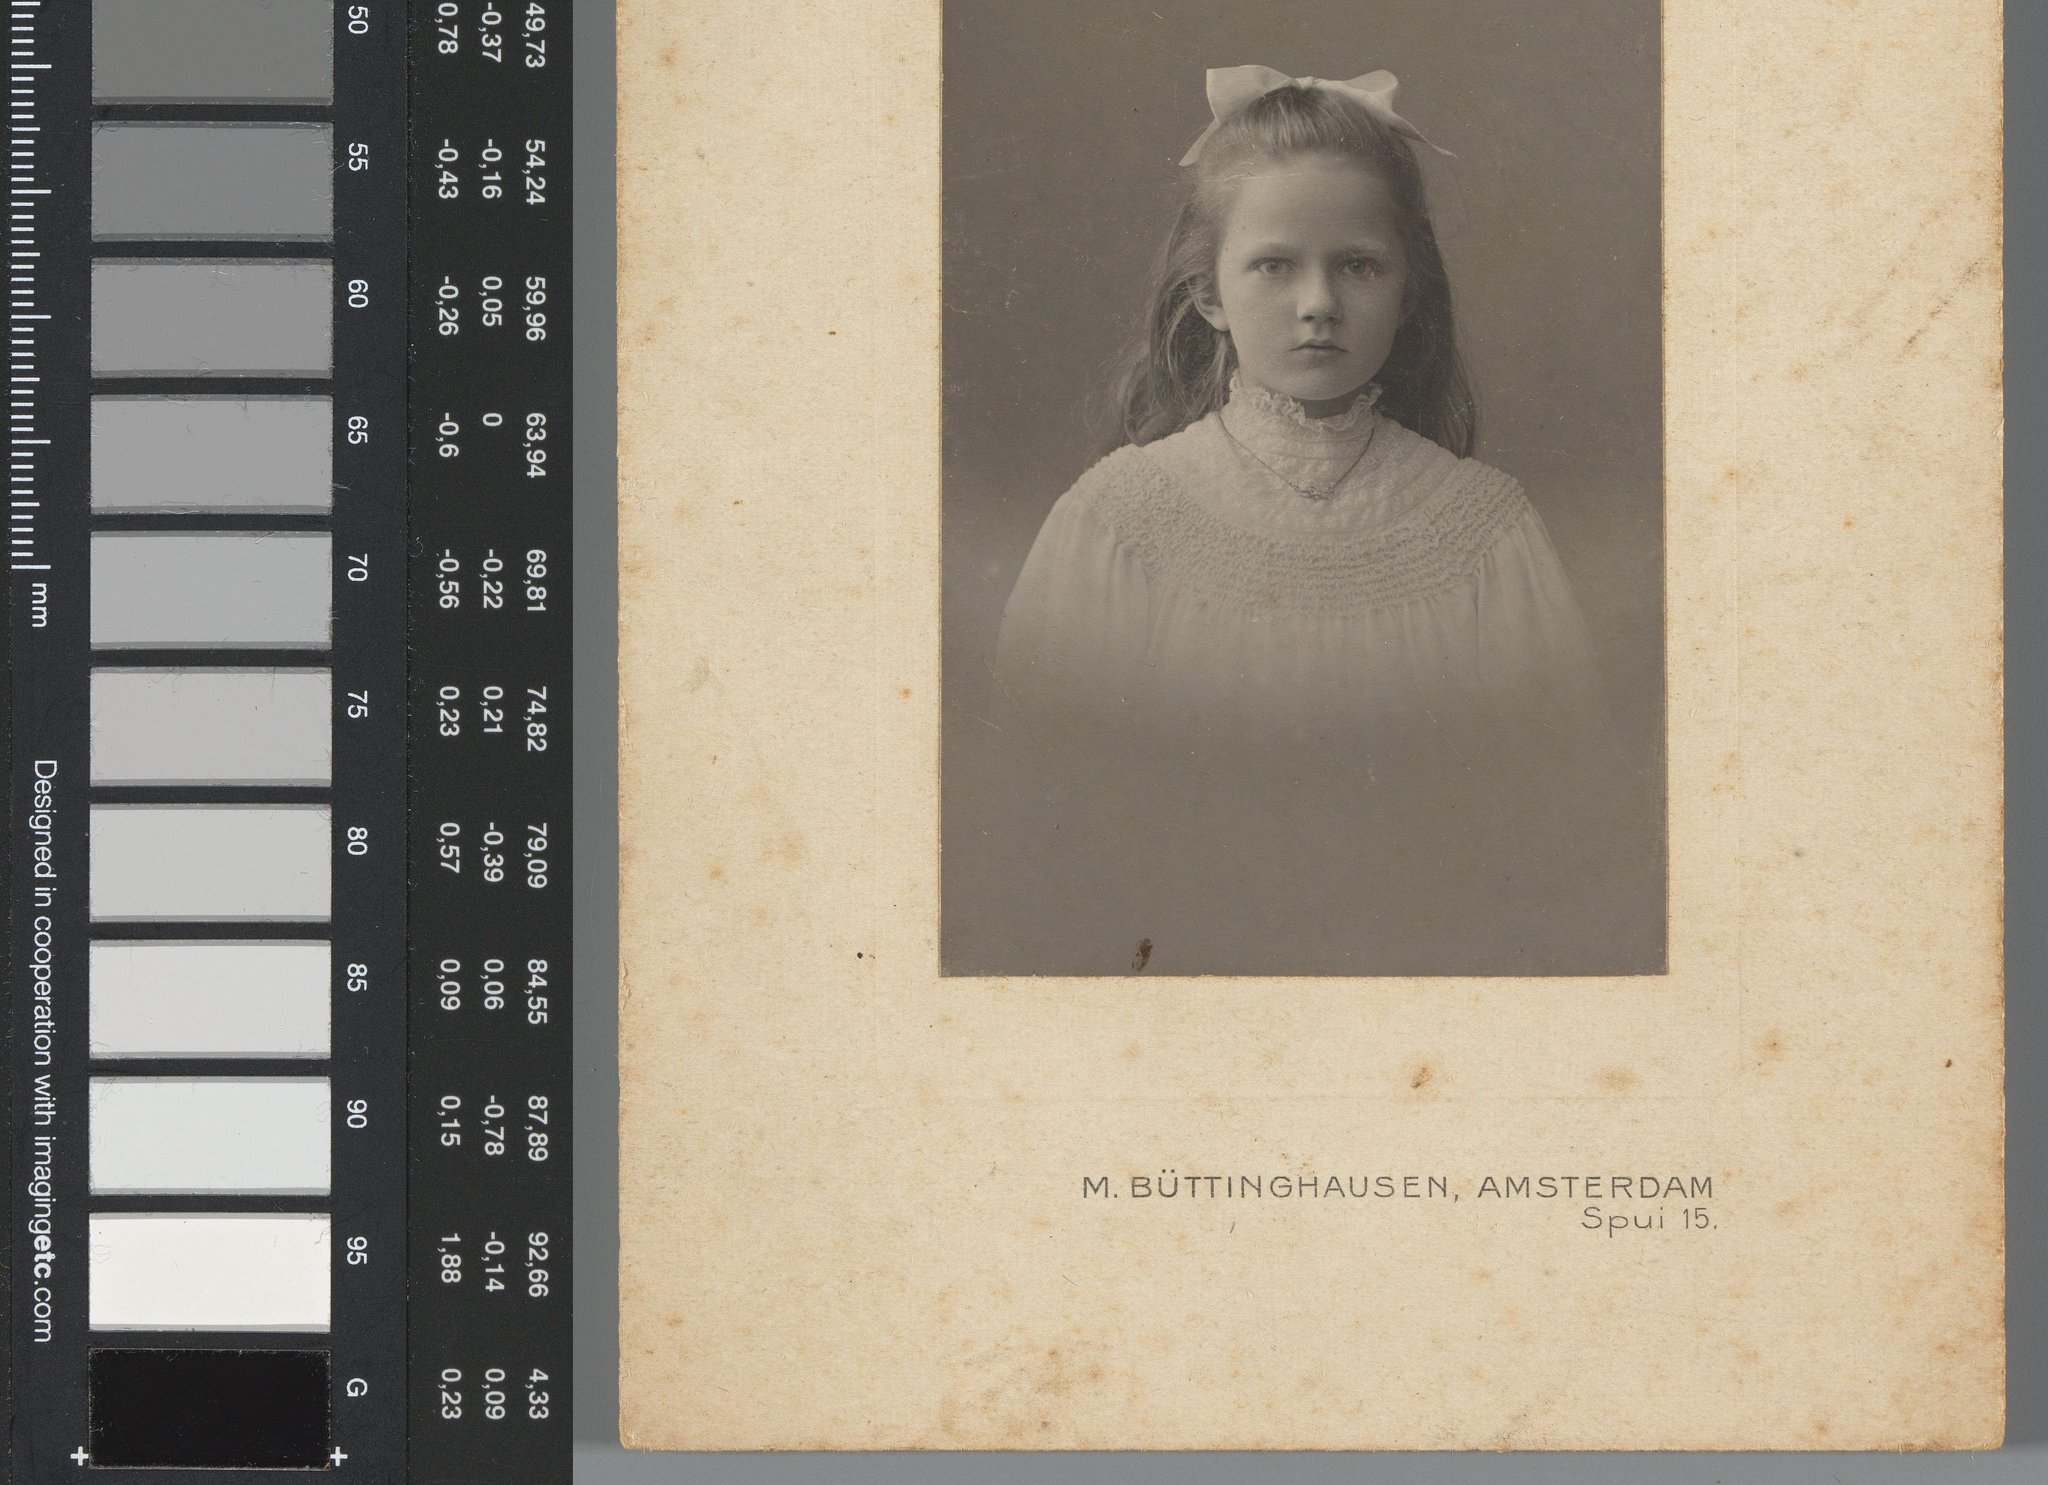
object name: photograph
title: Portret van van een dochter van Piet Onnen en Emilie van den Berg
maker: max büttinghausen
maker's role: fotograaf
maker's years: 1847-1906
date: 1900-1915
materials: photographic support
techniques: photography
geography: spui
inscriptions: name: ‘M. BÜTTINGHAUSEN, AMSTERDAM / Spui 15.’